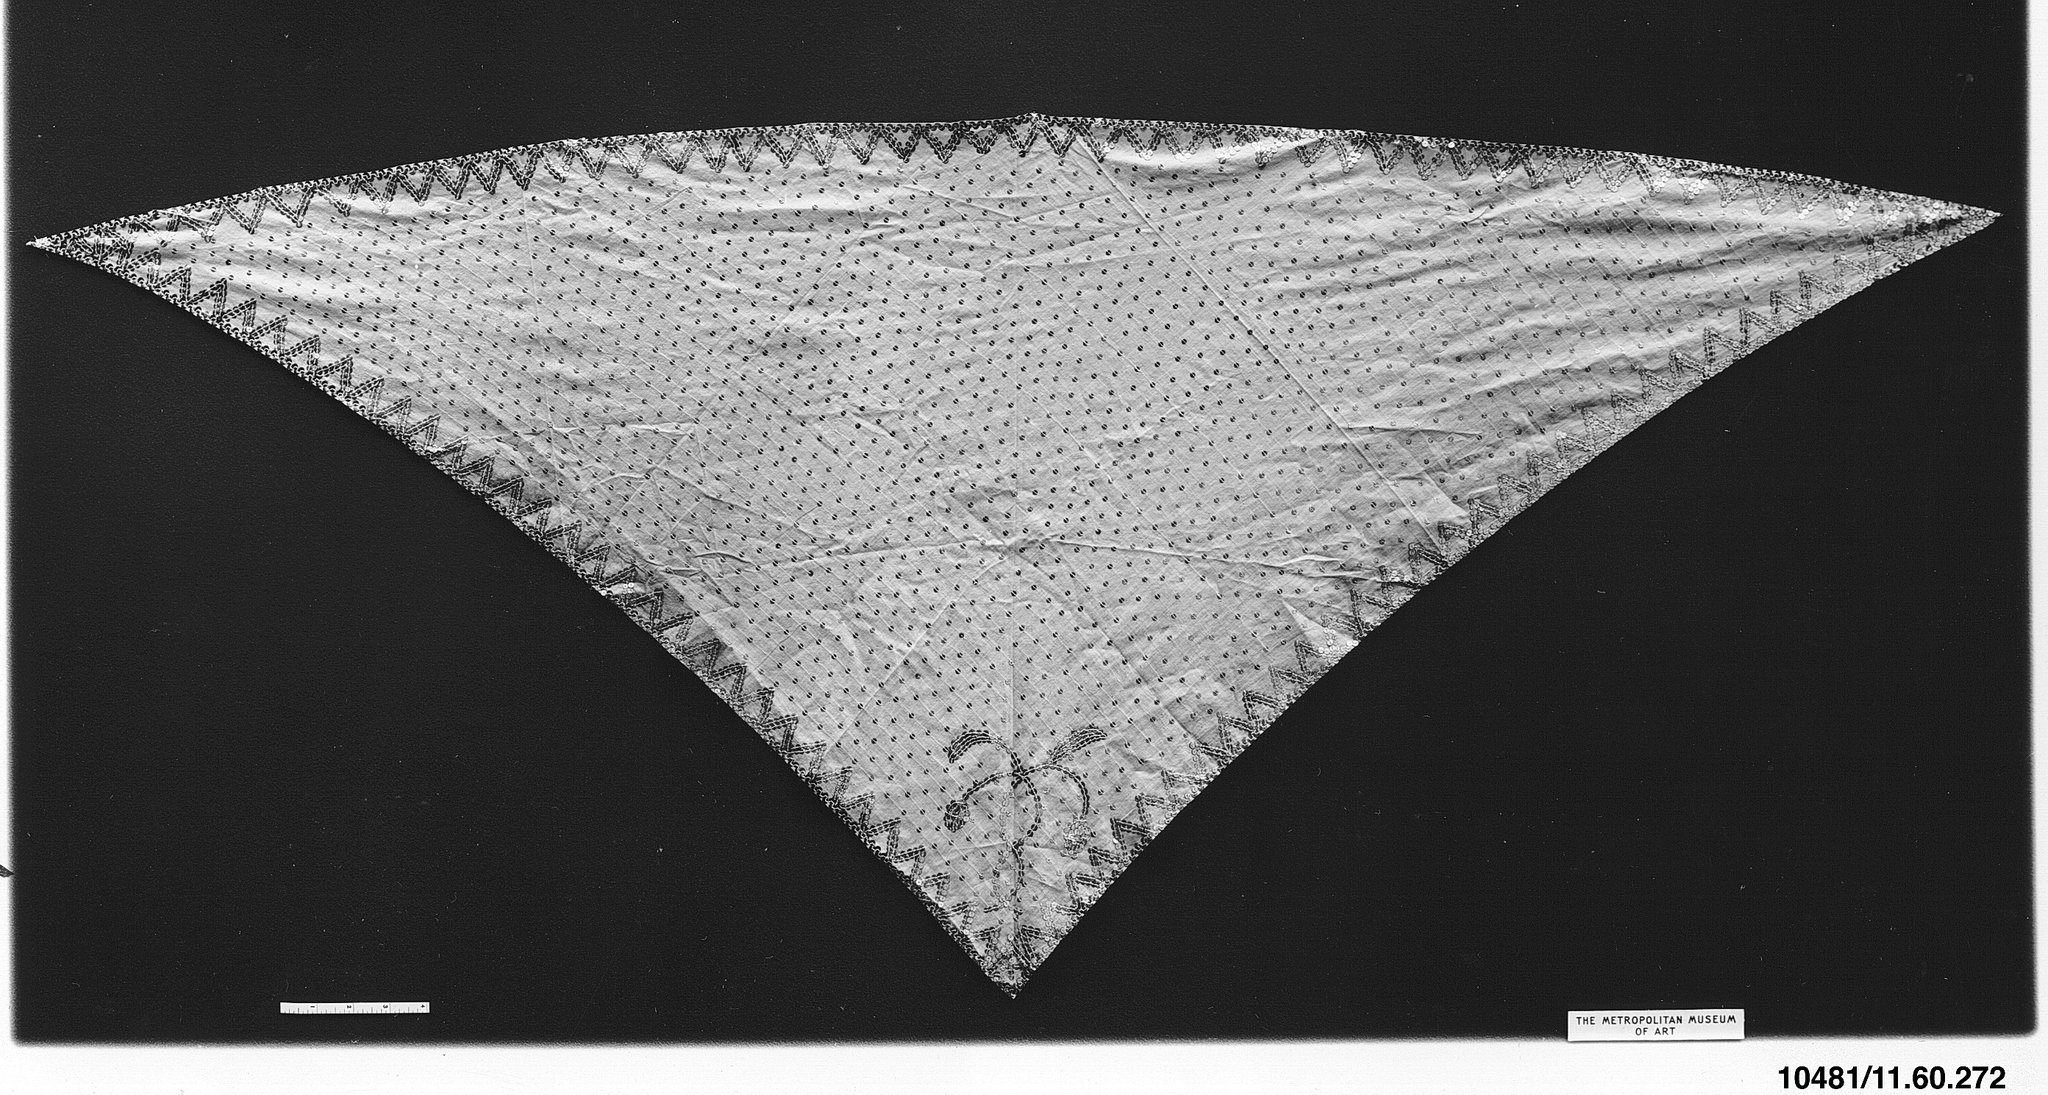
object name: kerchief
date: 1800-1805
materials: cotton